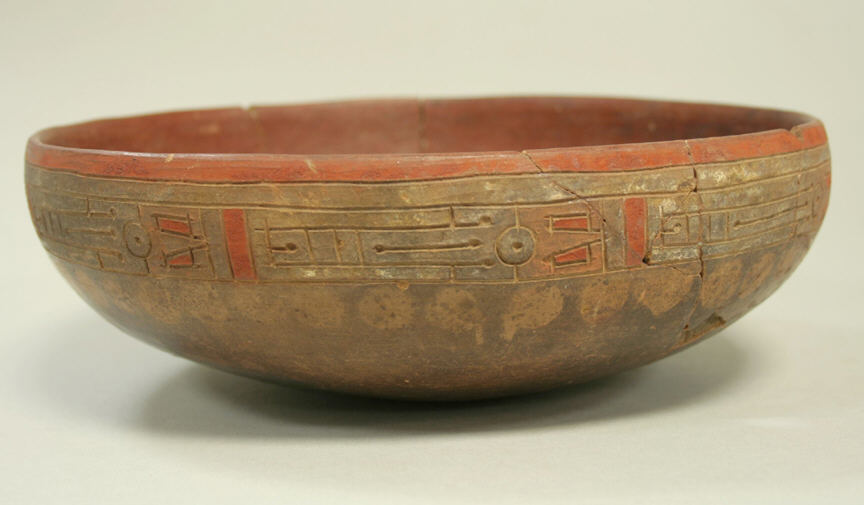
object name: bowl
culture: paracas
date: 500-201 BCE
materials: ceramic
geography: peru